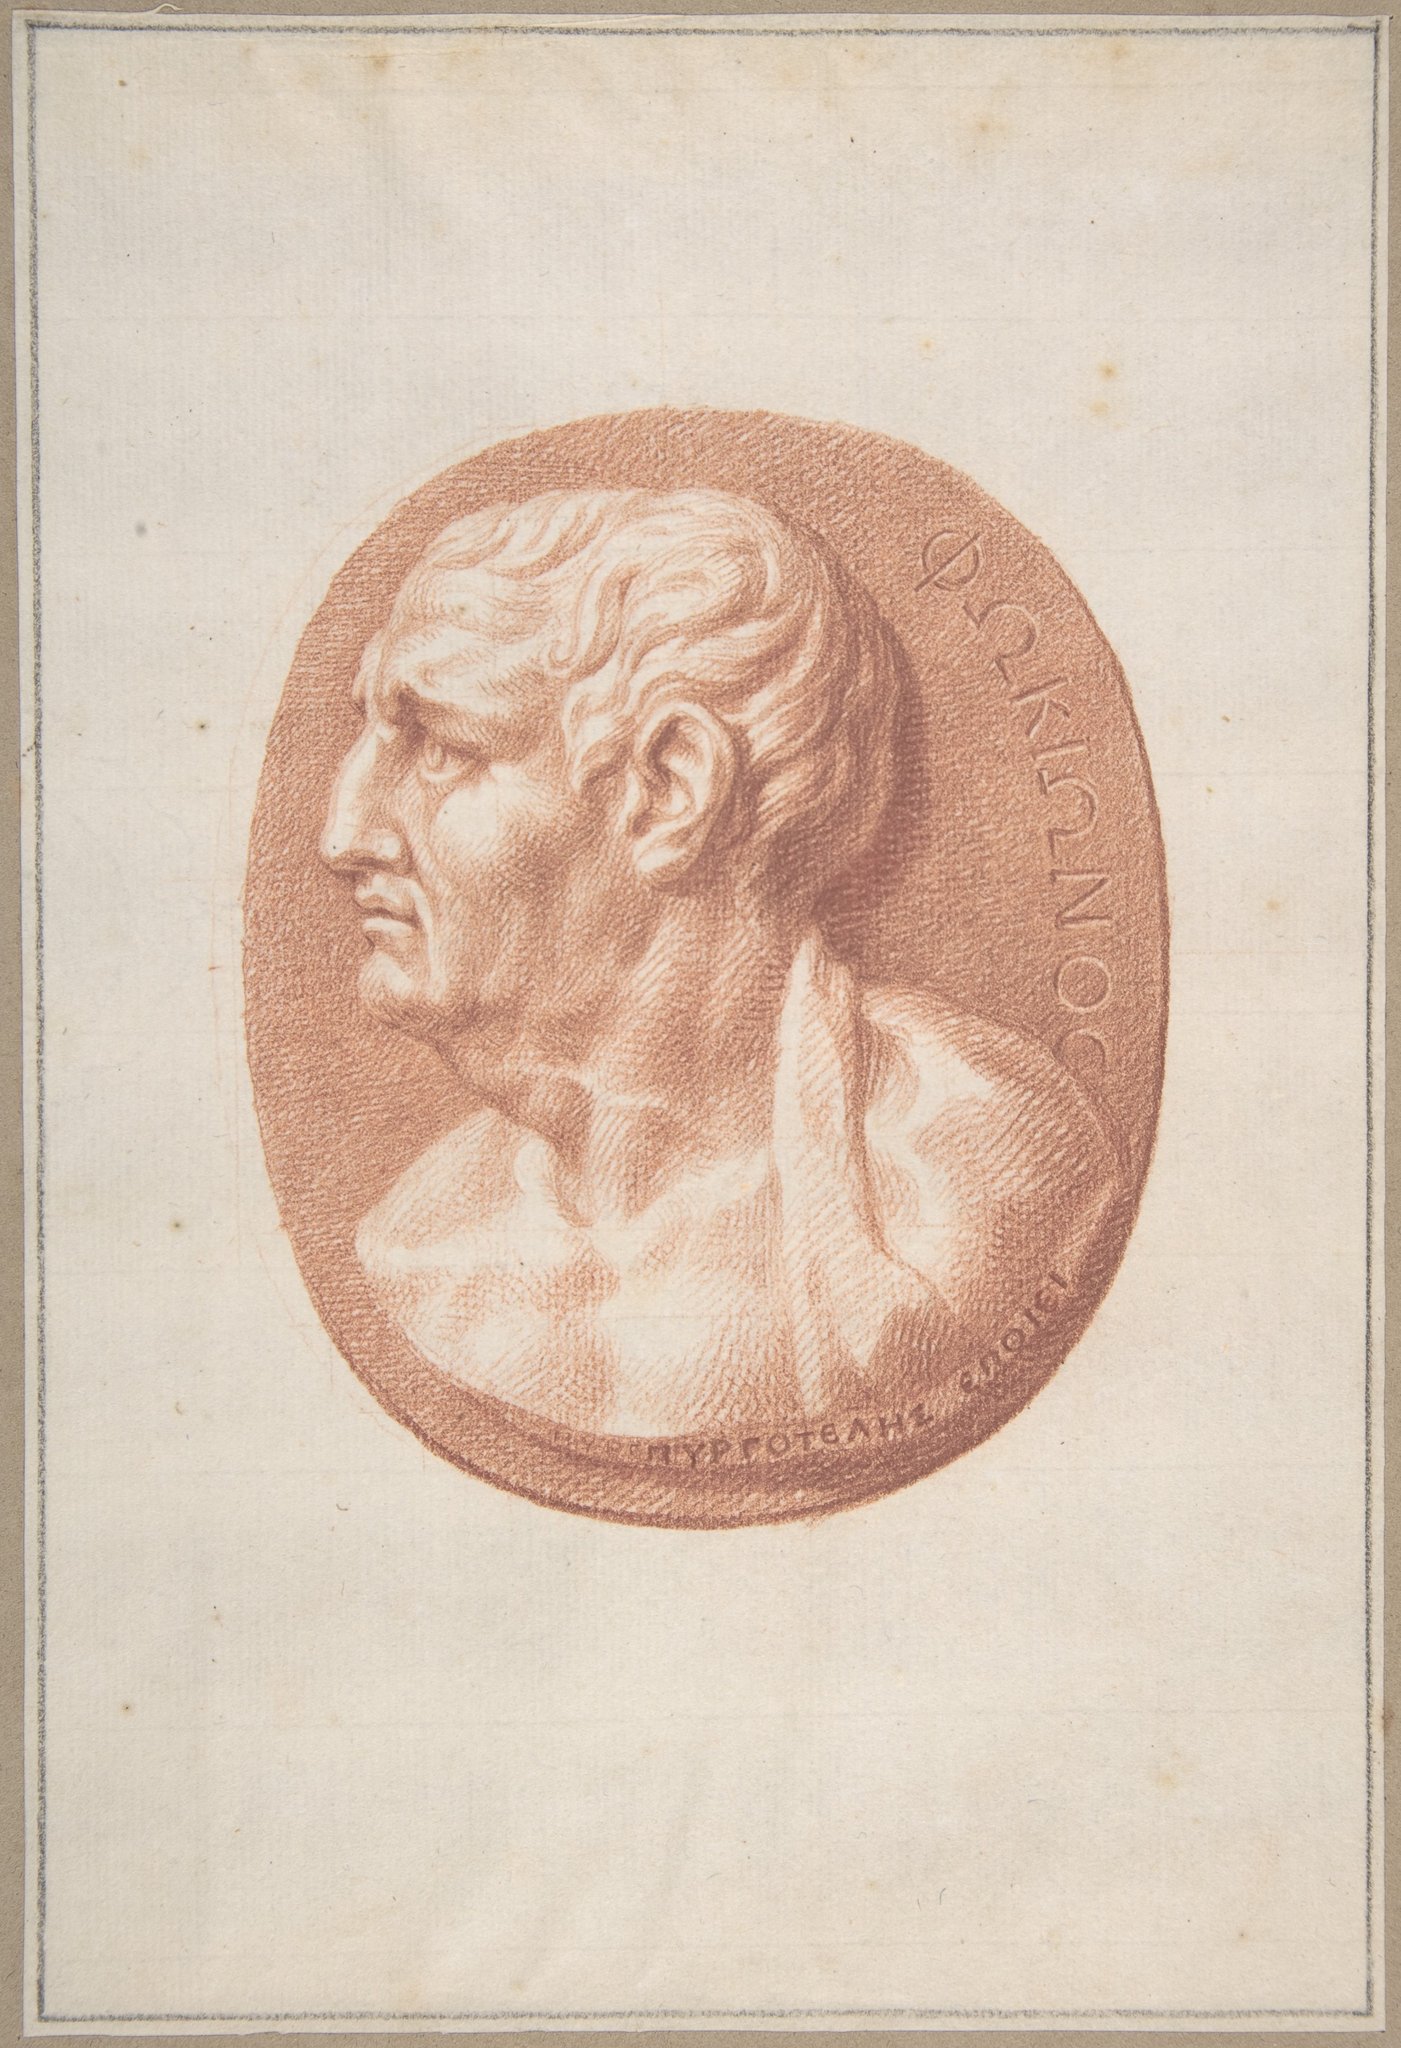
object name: drawing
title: Presumed Portrait of Phocion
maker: bernard picart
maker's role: artist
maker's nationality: french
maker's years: 1673-1733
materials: chalk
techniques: drawing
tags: men,profiles